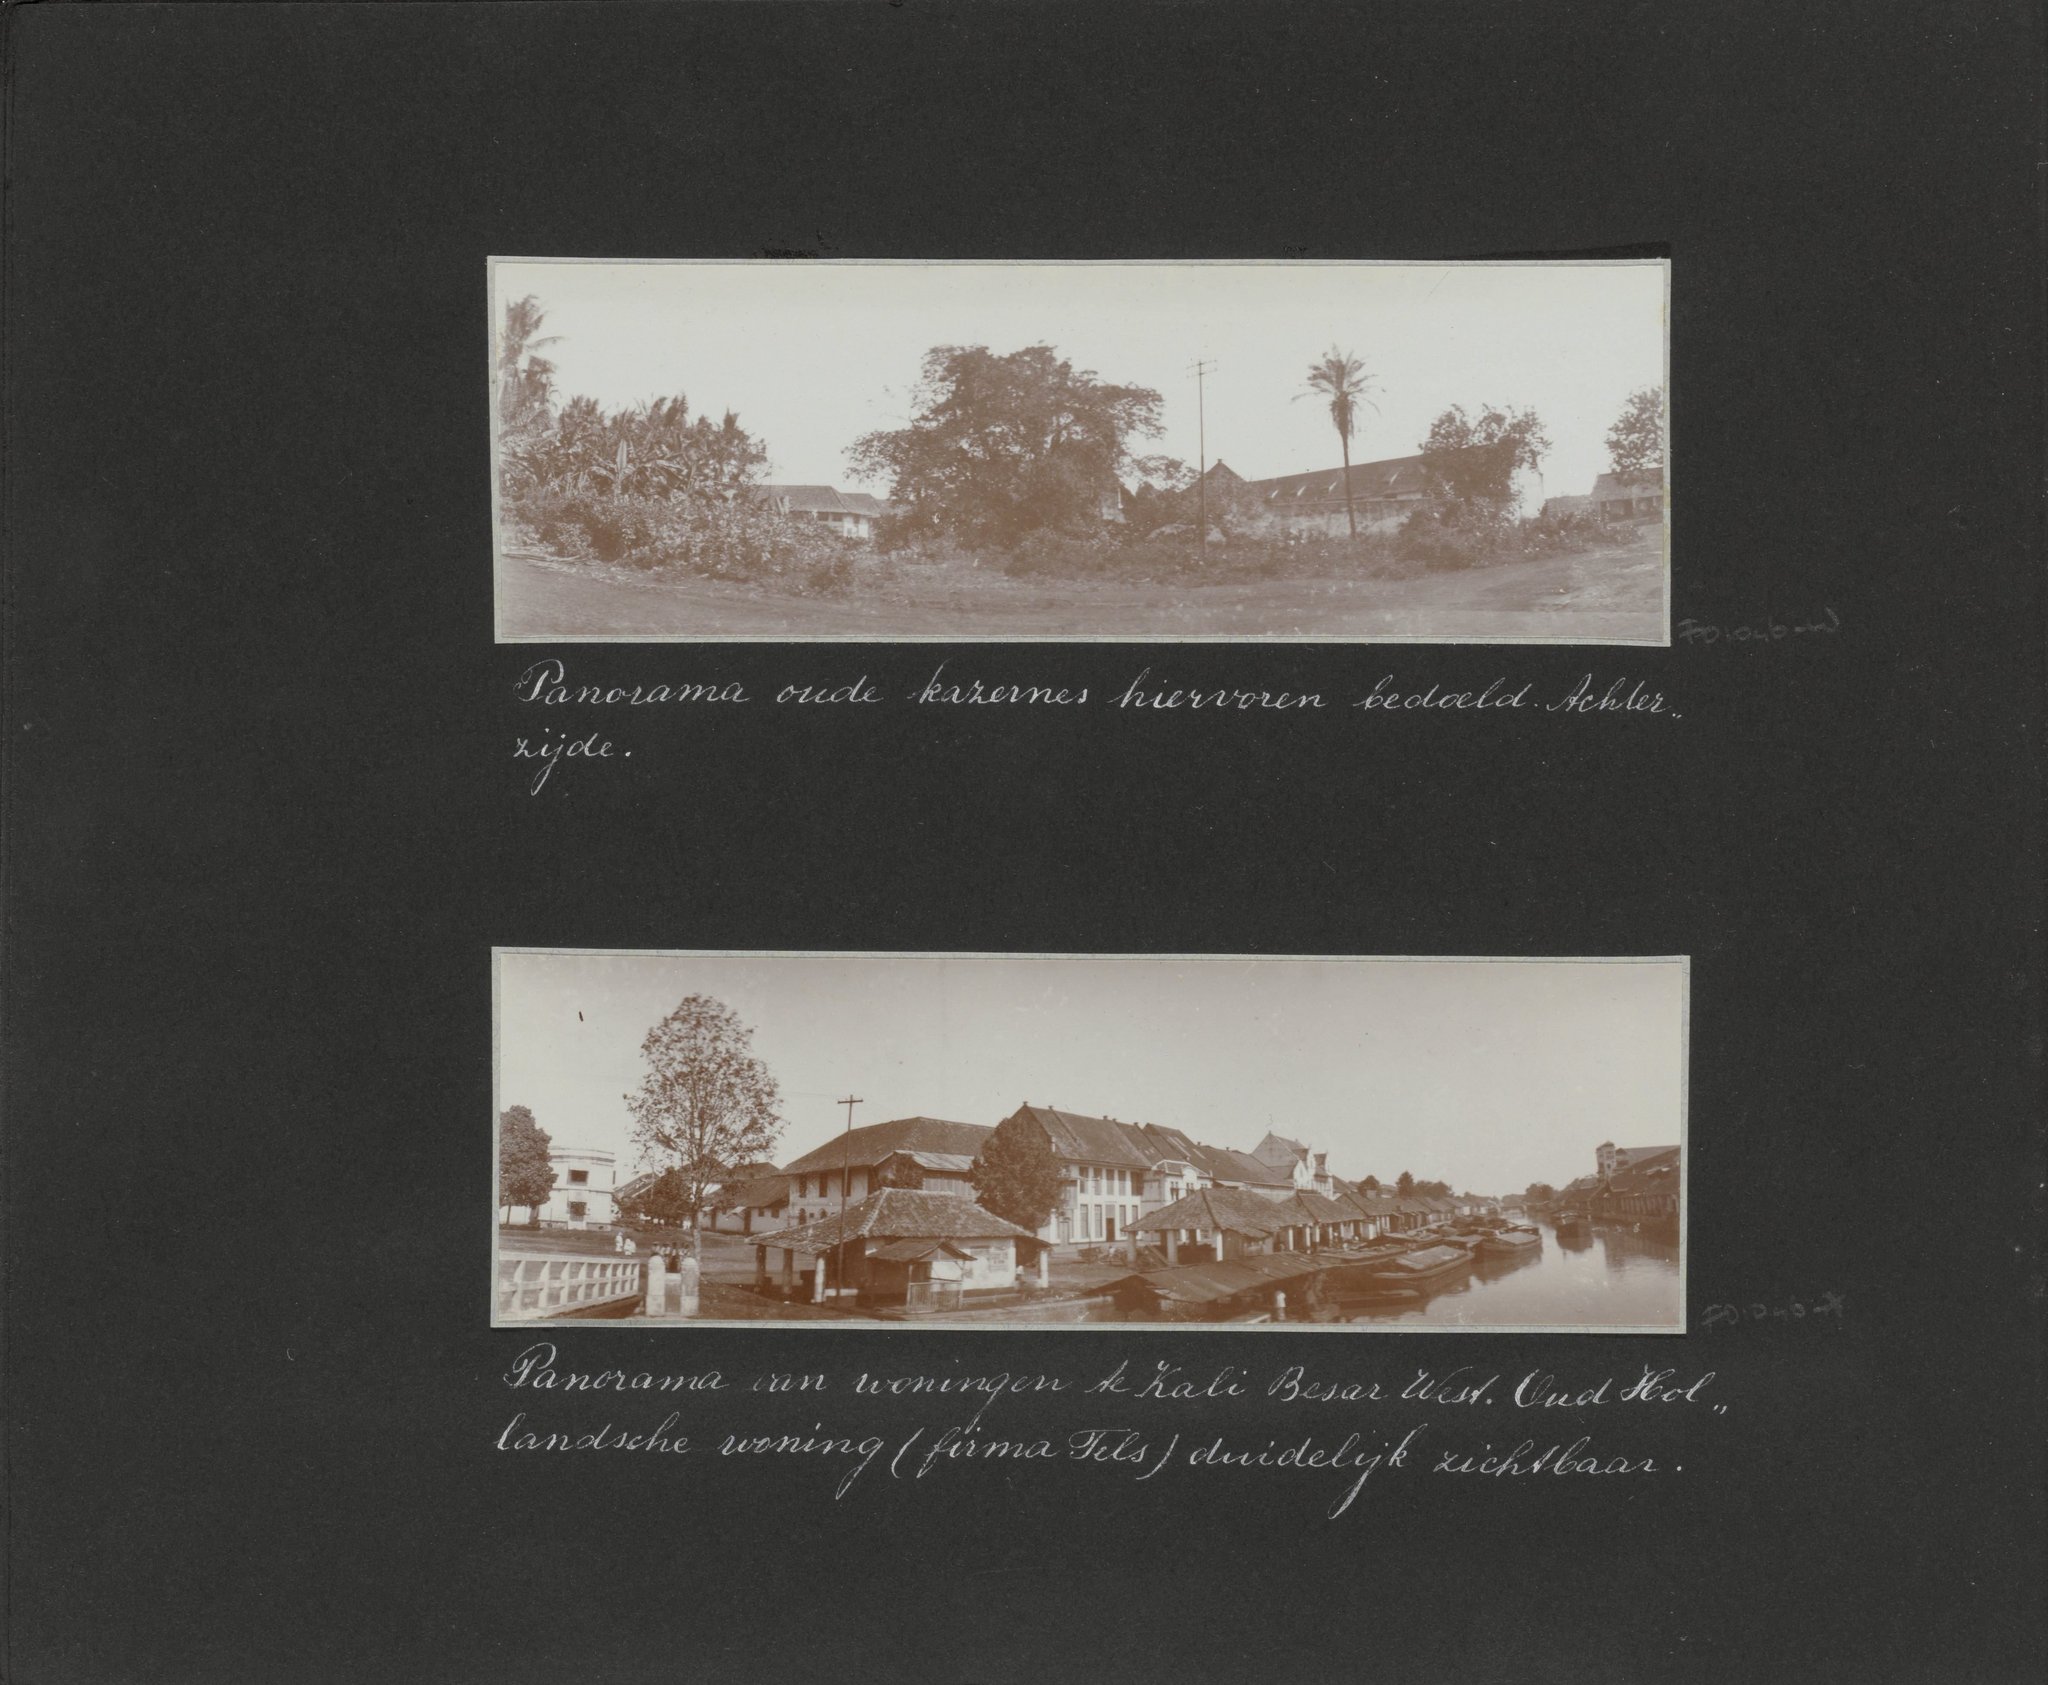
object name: album leaf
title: Panorama van de achterzijde van de oude kazernes in Batavia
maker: Anonymous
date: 1920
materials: paper, photographic support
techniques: gelatin silver print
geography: batavia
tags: barracks, prospect of city, town panorama, silhouette of city, dutch east indies, the, batavia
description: Onderdeel van Reisalbum met foto's van Batavia.